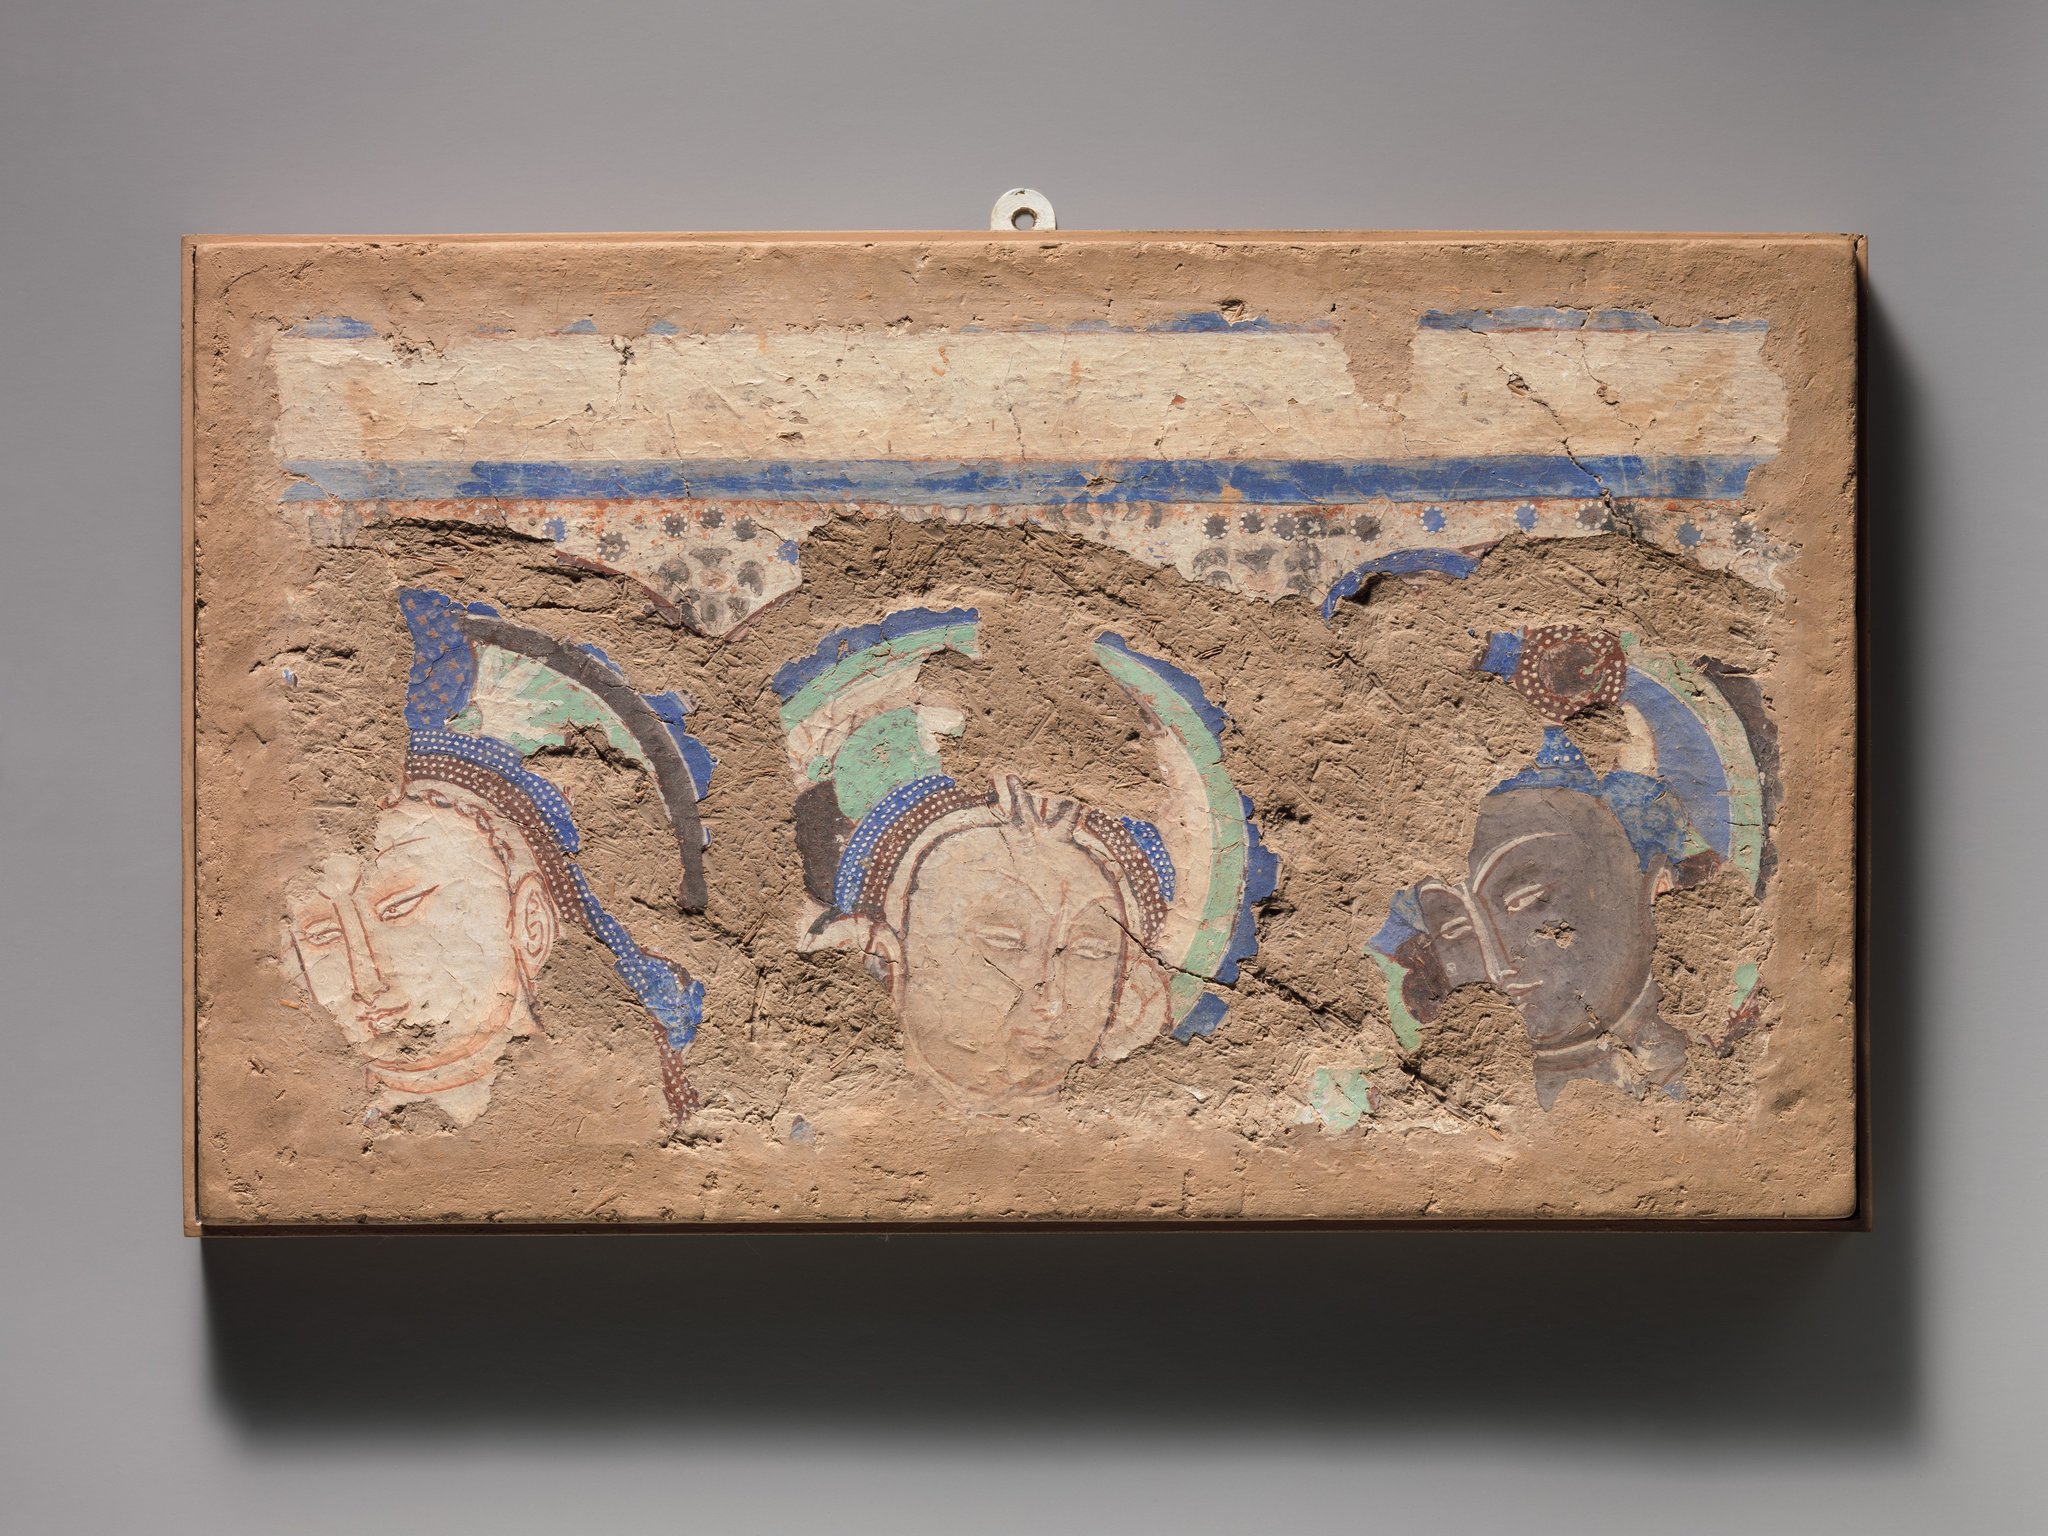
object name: wall painting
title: Three Celestial Attendants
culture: chinese, xinjiang uyghur autonomous region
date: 501-700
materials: mud, pigment, plaster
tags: faces,men,women